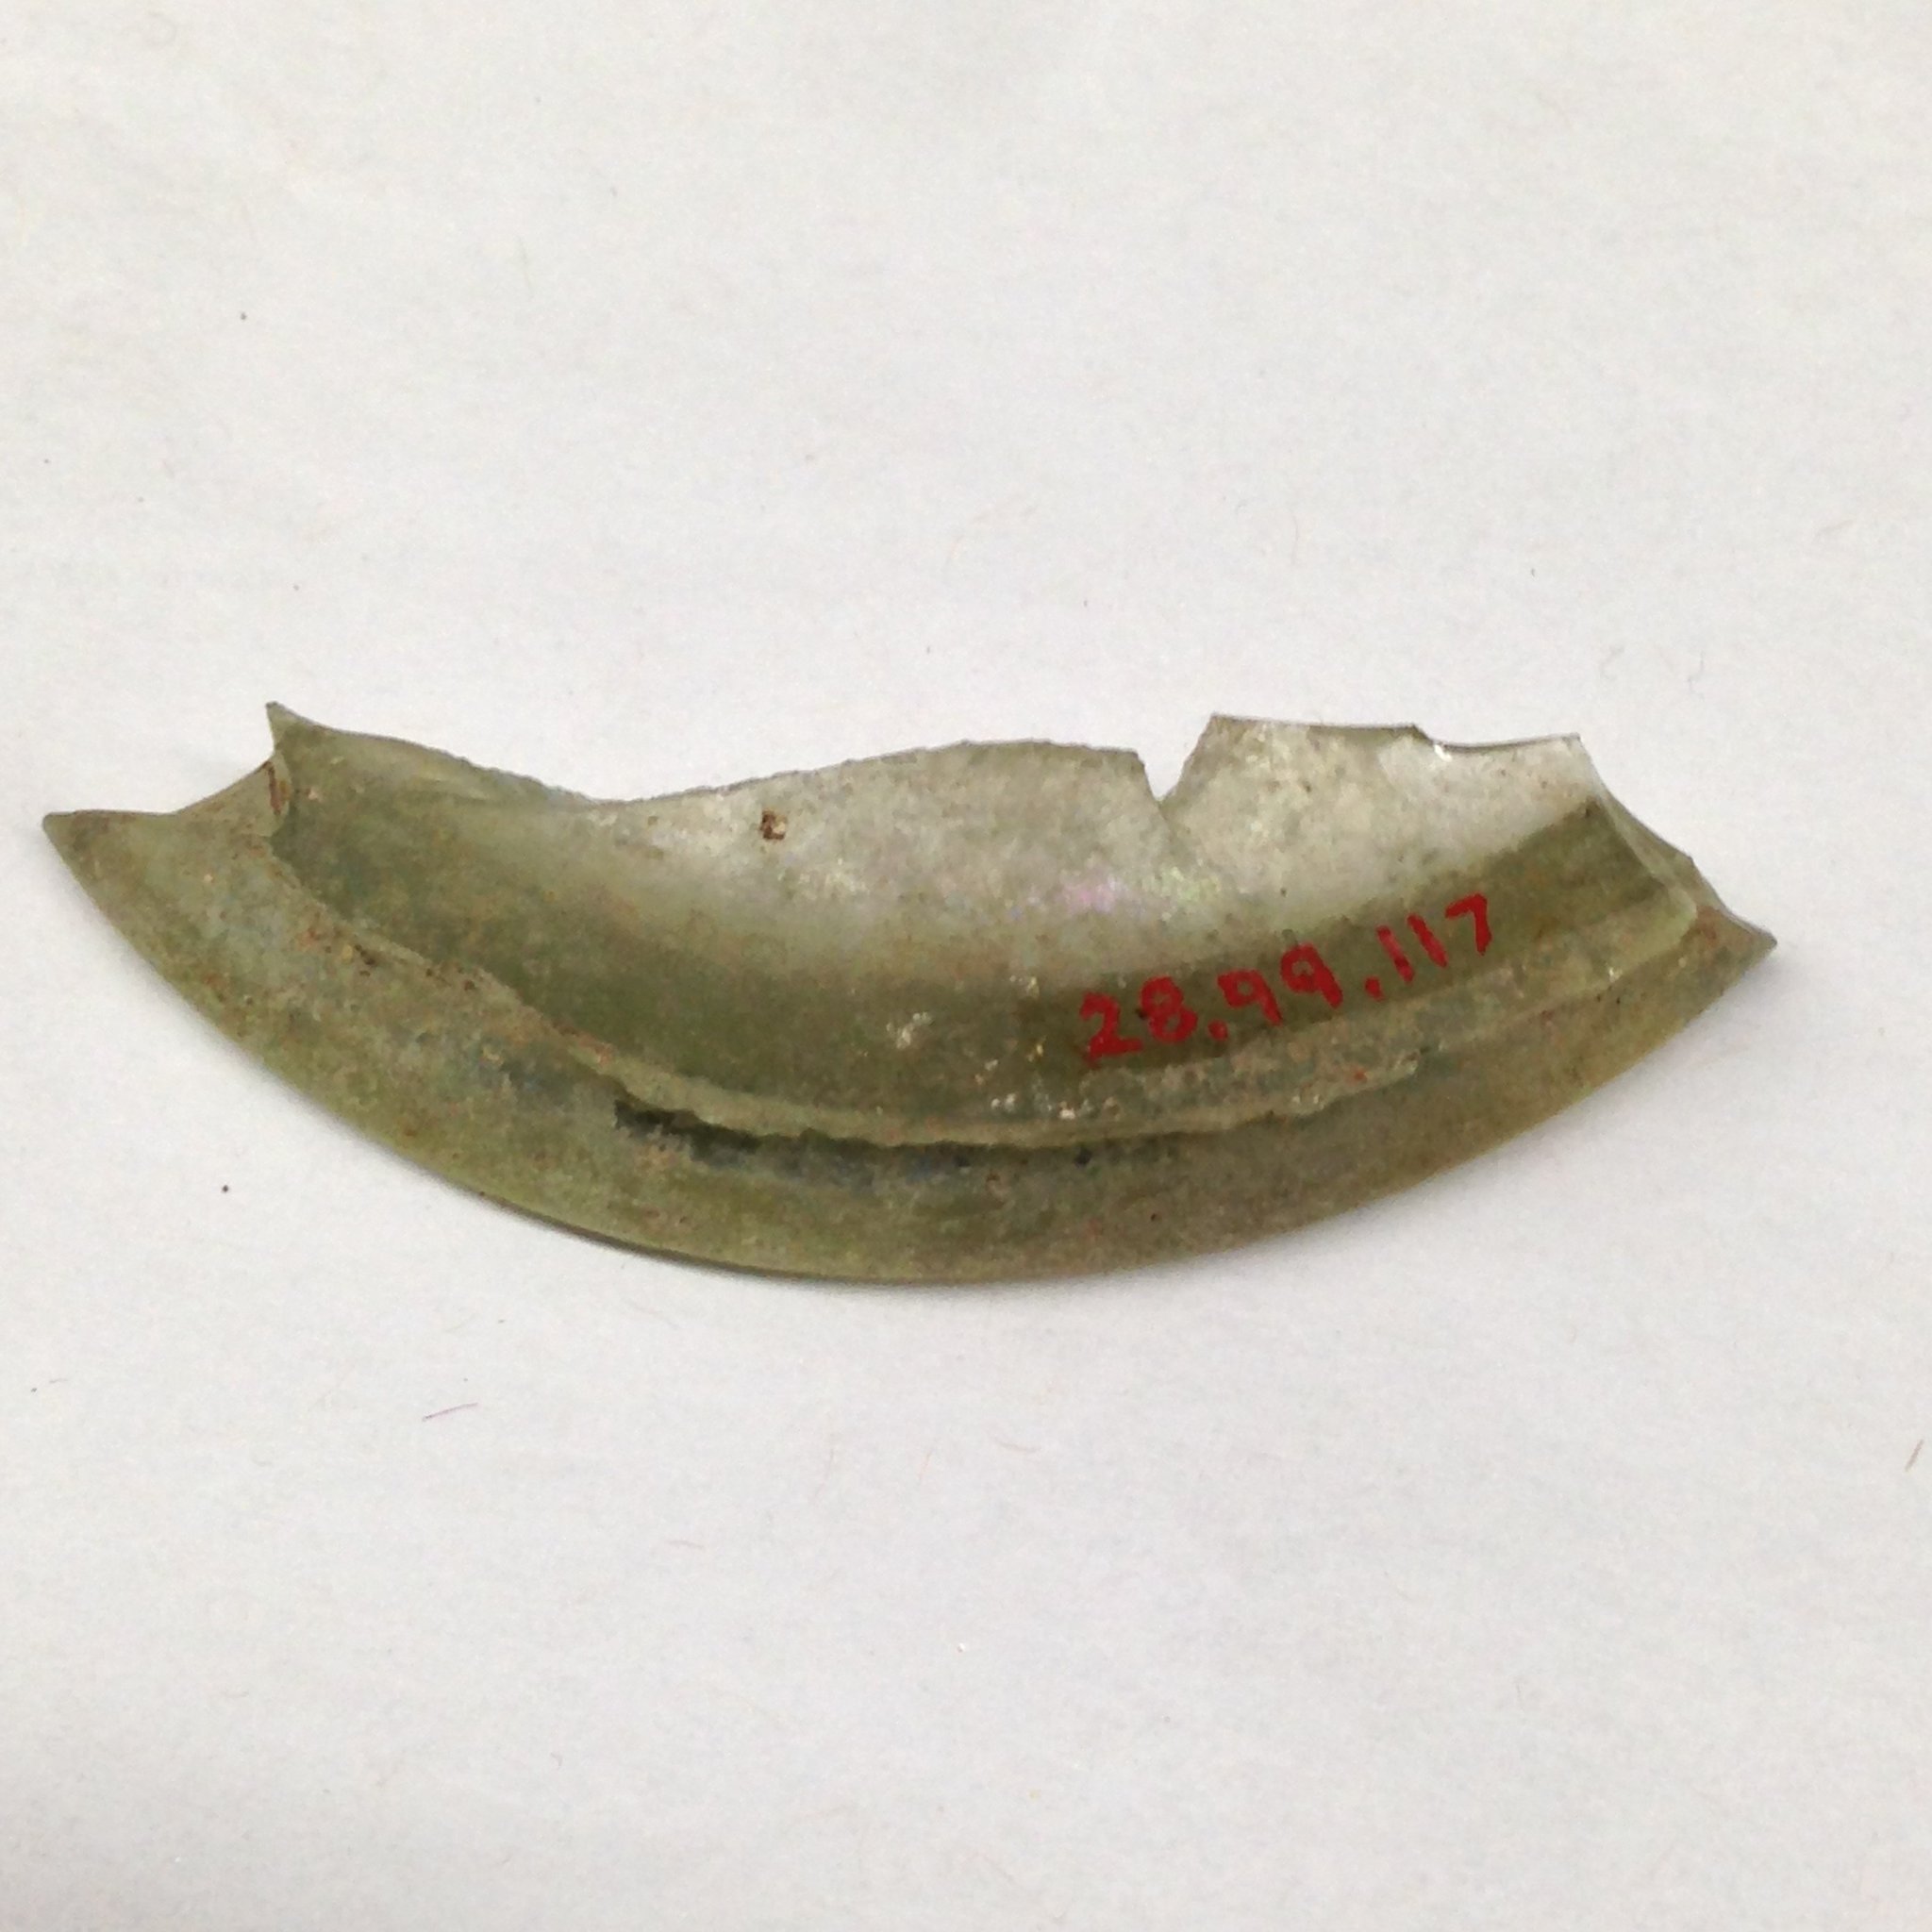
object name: fragment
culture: european or middle eastern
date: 1150-1250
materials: ceramic, glass